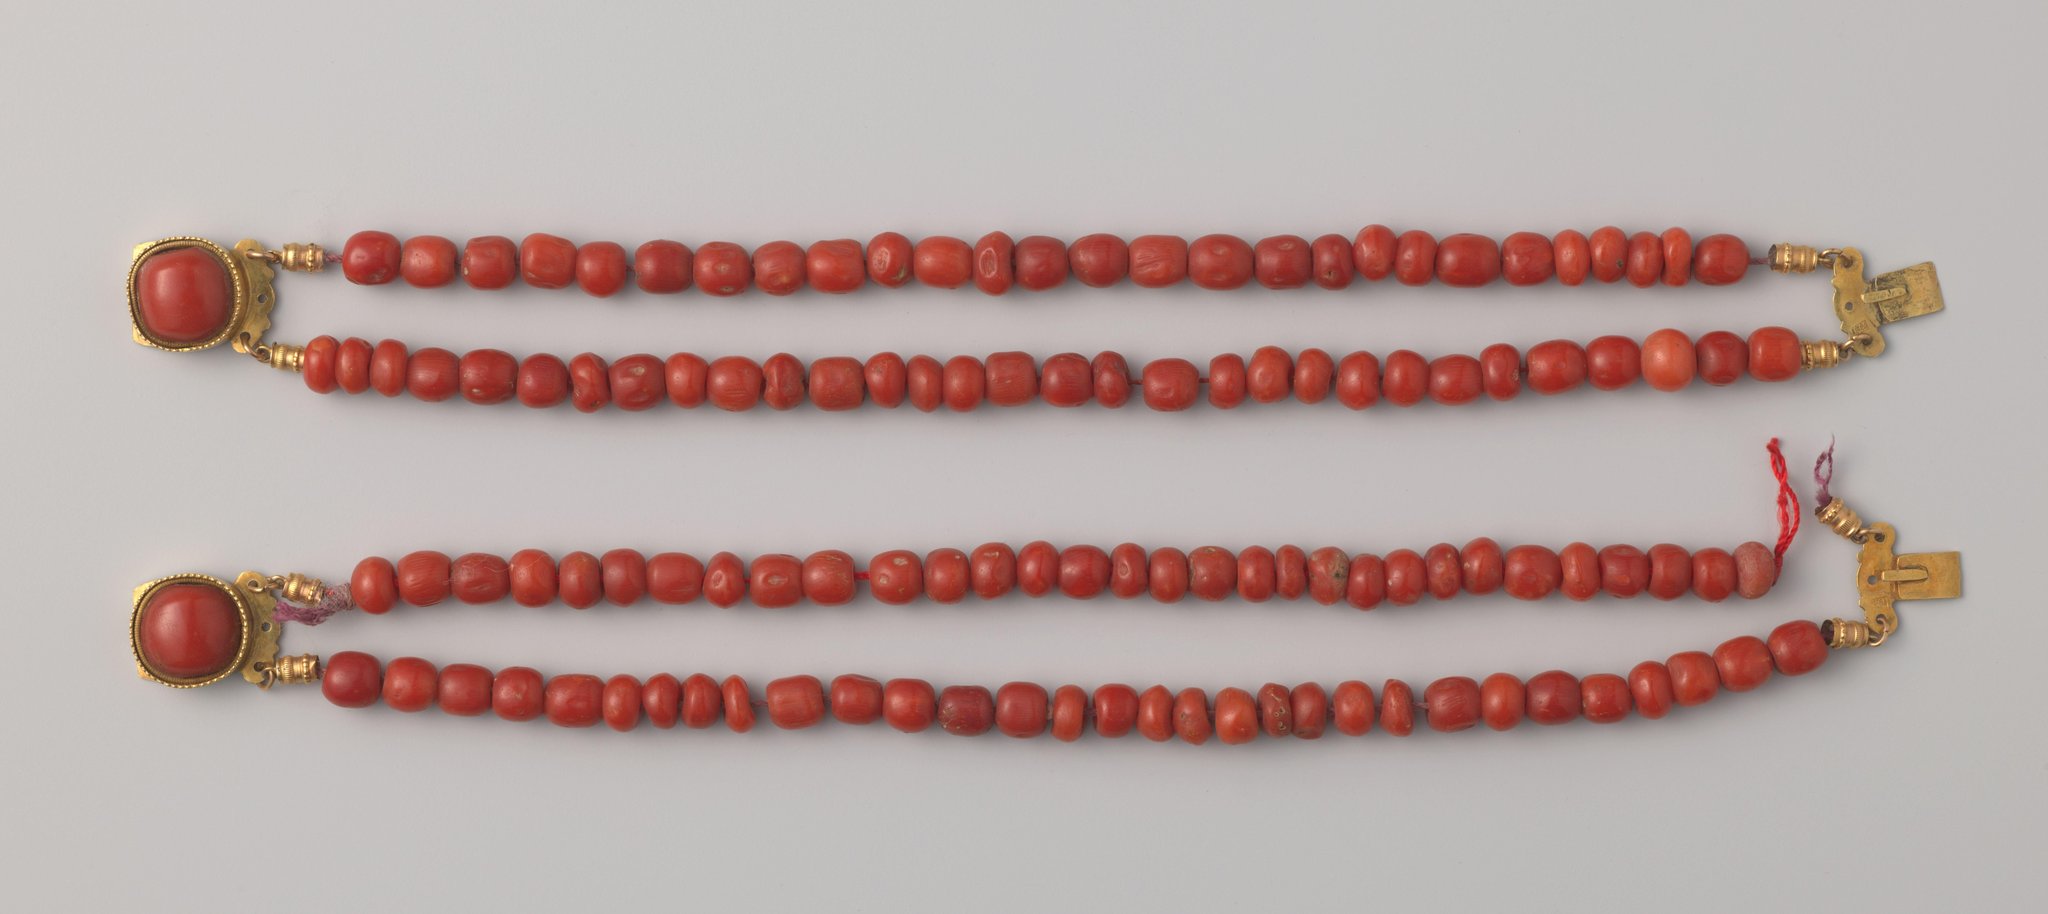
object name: streeksieraad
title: Twee armbanden met bloedkoraal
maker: adriaan haast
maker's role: goldsmith, jeweler, silversmith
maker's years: 1822-1878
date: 1850-1878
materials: gold, coral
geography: etten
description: Twee armbanden van geregen bloedkoralen met een gouden slot. Het slot is gemerkt.